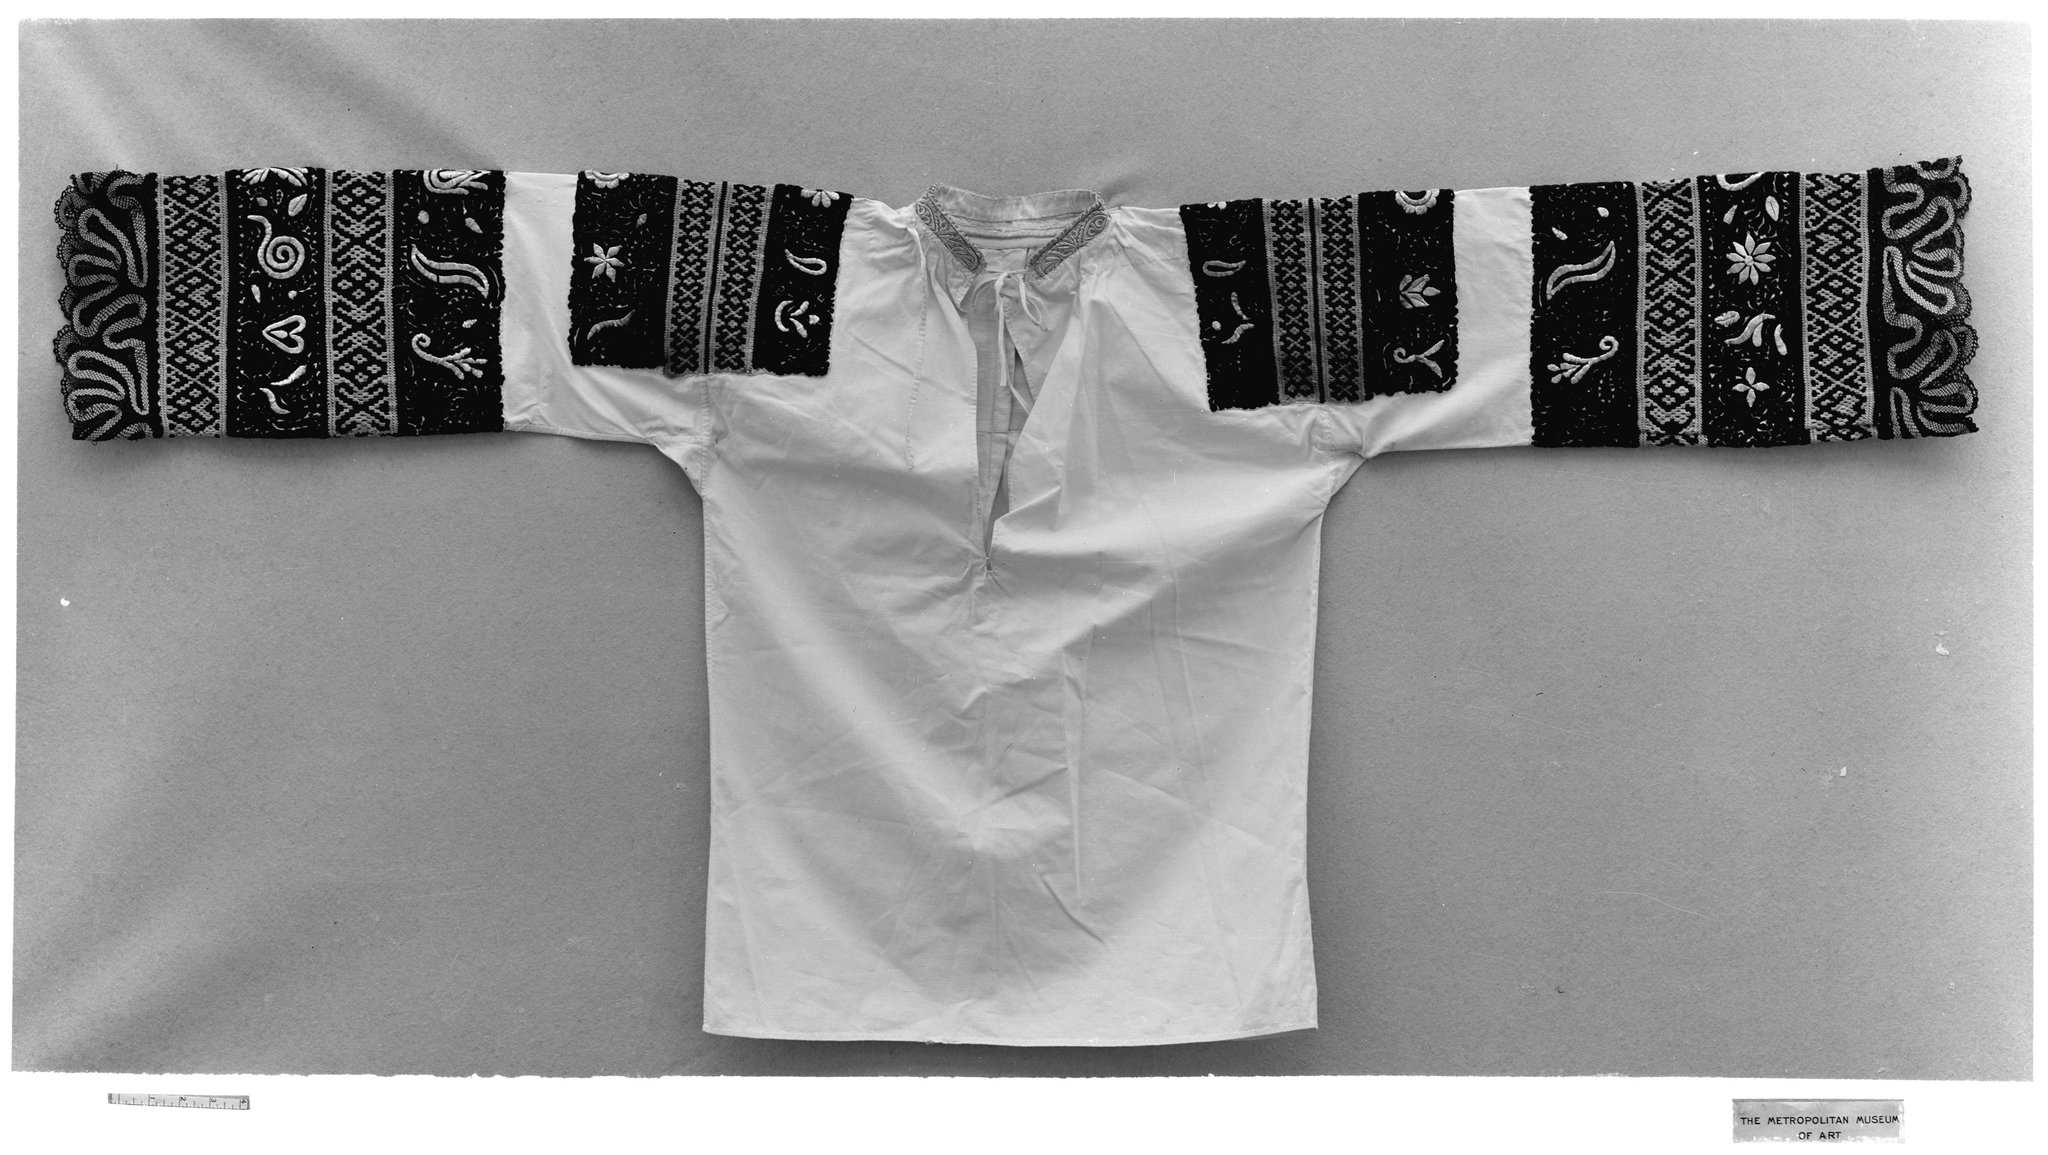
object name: shirt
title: Man's shirt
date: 1801-1900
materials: linen, metal thread